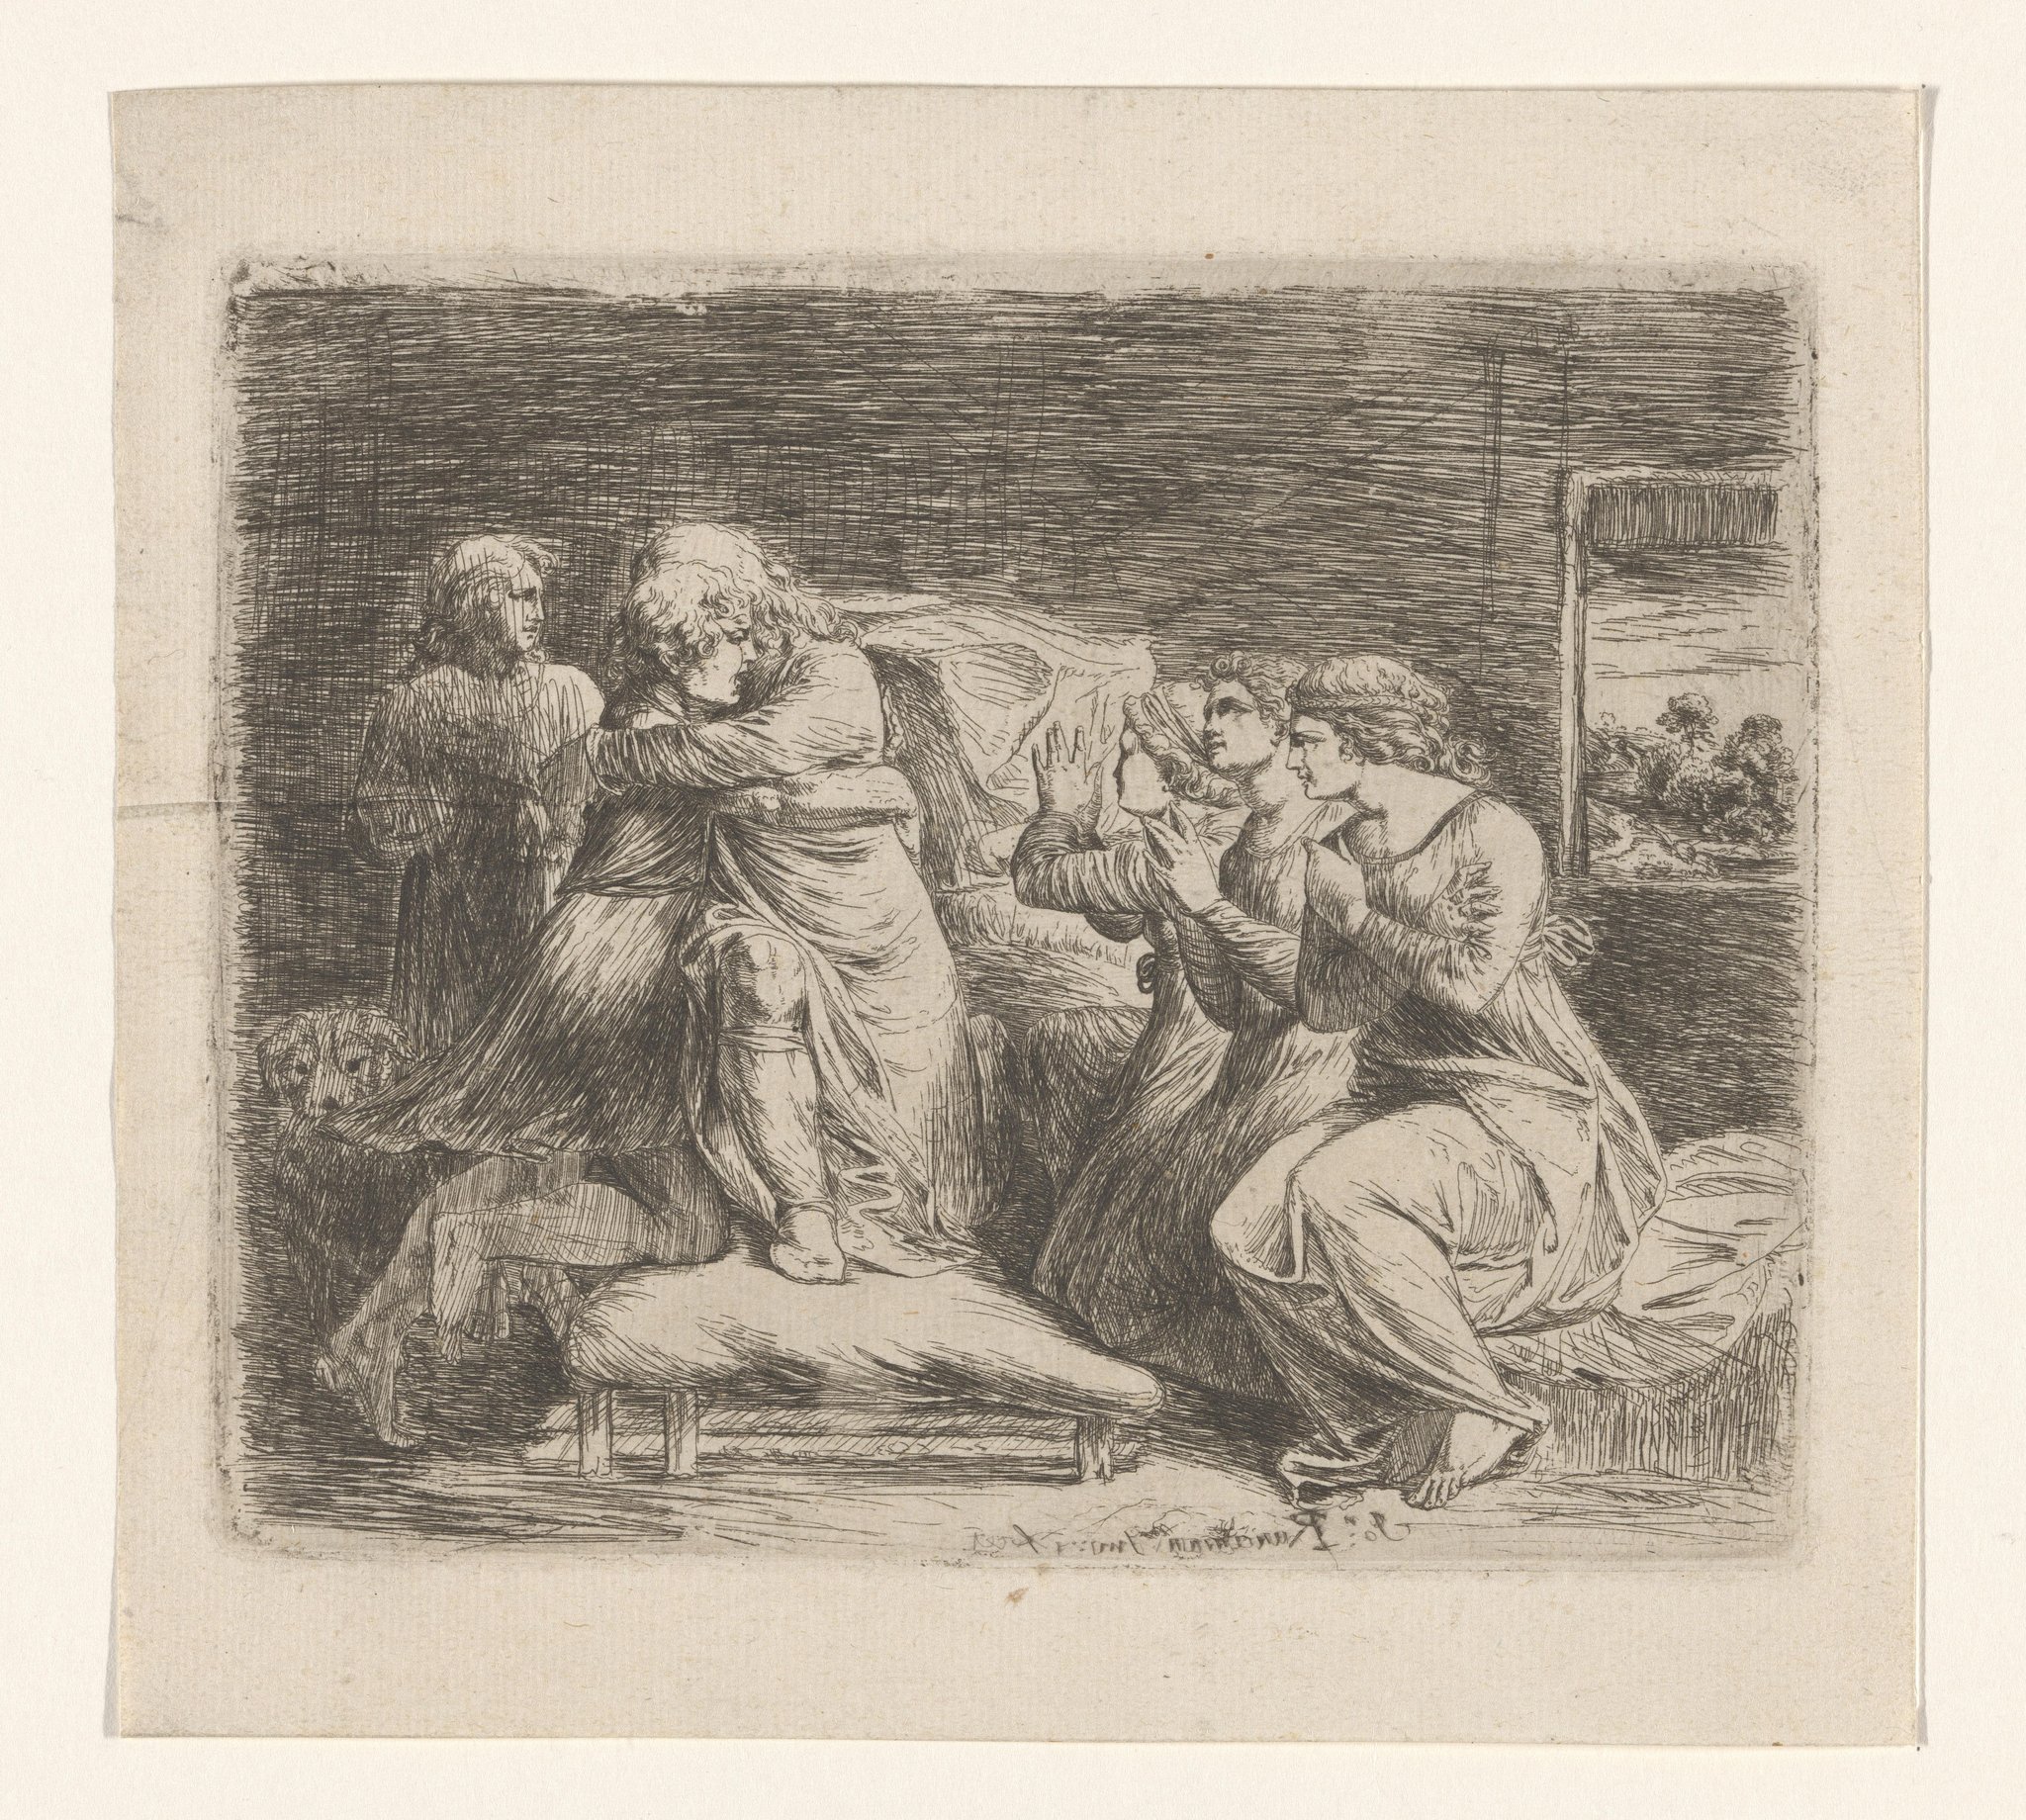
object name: print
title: De terugkeer van de verloren zoon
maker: john runciman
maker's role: artist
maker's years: 1744-1766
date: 1767-1768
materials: ink, paper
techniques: etching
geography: rome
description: De Schotse kunstenaar John Runciman reisde met zijn oudere broer Alexander in 1767 naar Rome. Hier schilderde hij een zelfportret (National Gallery of Scotland, Edinburgh) en maakte deze ets. In 1768 raakte hij besmet met tuberculose en vernielde in psychische nood een deel van zijn werk. Hij vertrok naar Napels waar hij in 1768 of 1769 overleed op 24- of 25-jarige leeftijd. Het overgeleverde oeuvre van John Runciman is klein en afdrukken van zijn twee bekende etsen zijn uiterst zeldzaam. Op de afdrukken van de Verloren zoon in Edinburgh en in het British Museum, Londen (2 exemplaren) ontbreekt het signatuur. In de onderhavige afdruk is onderaan een signatuur in spiegelbeeld zichtbaar dat met droge naald in de plaat is gekrast. Het betreft dus een vooralsnog onbeschreven tweede staat van de ets.